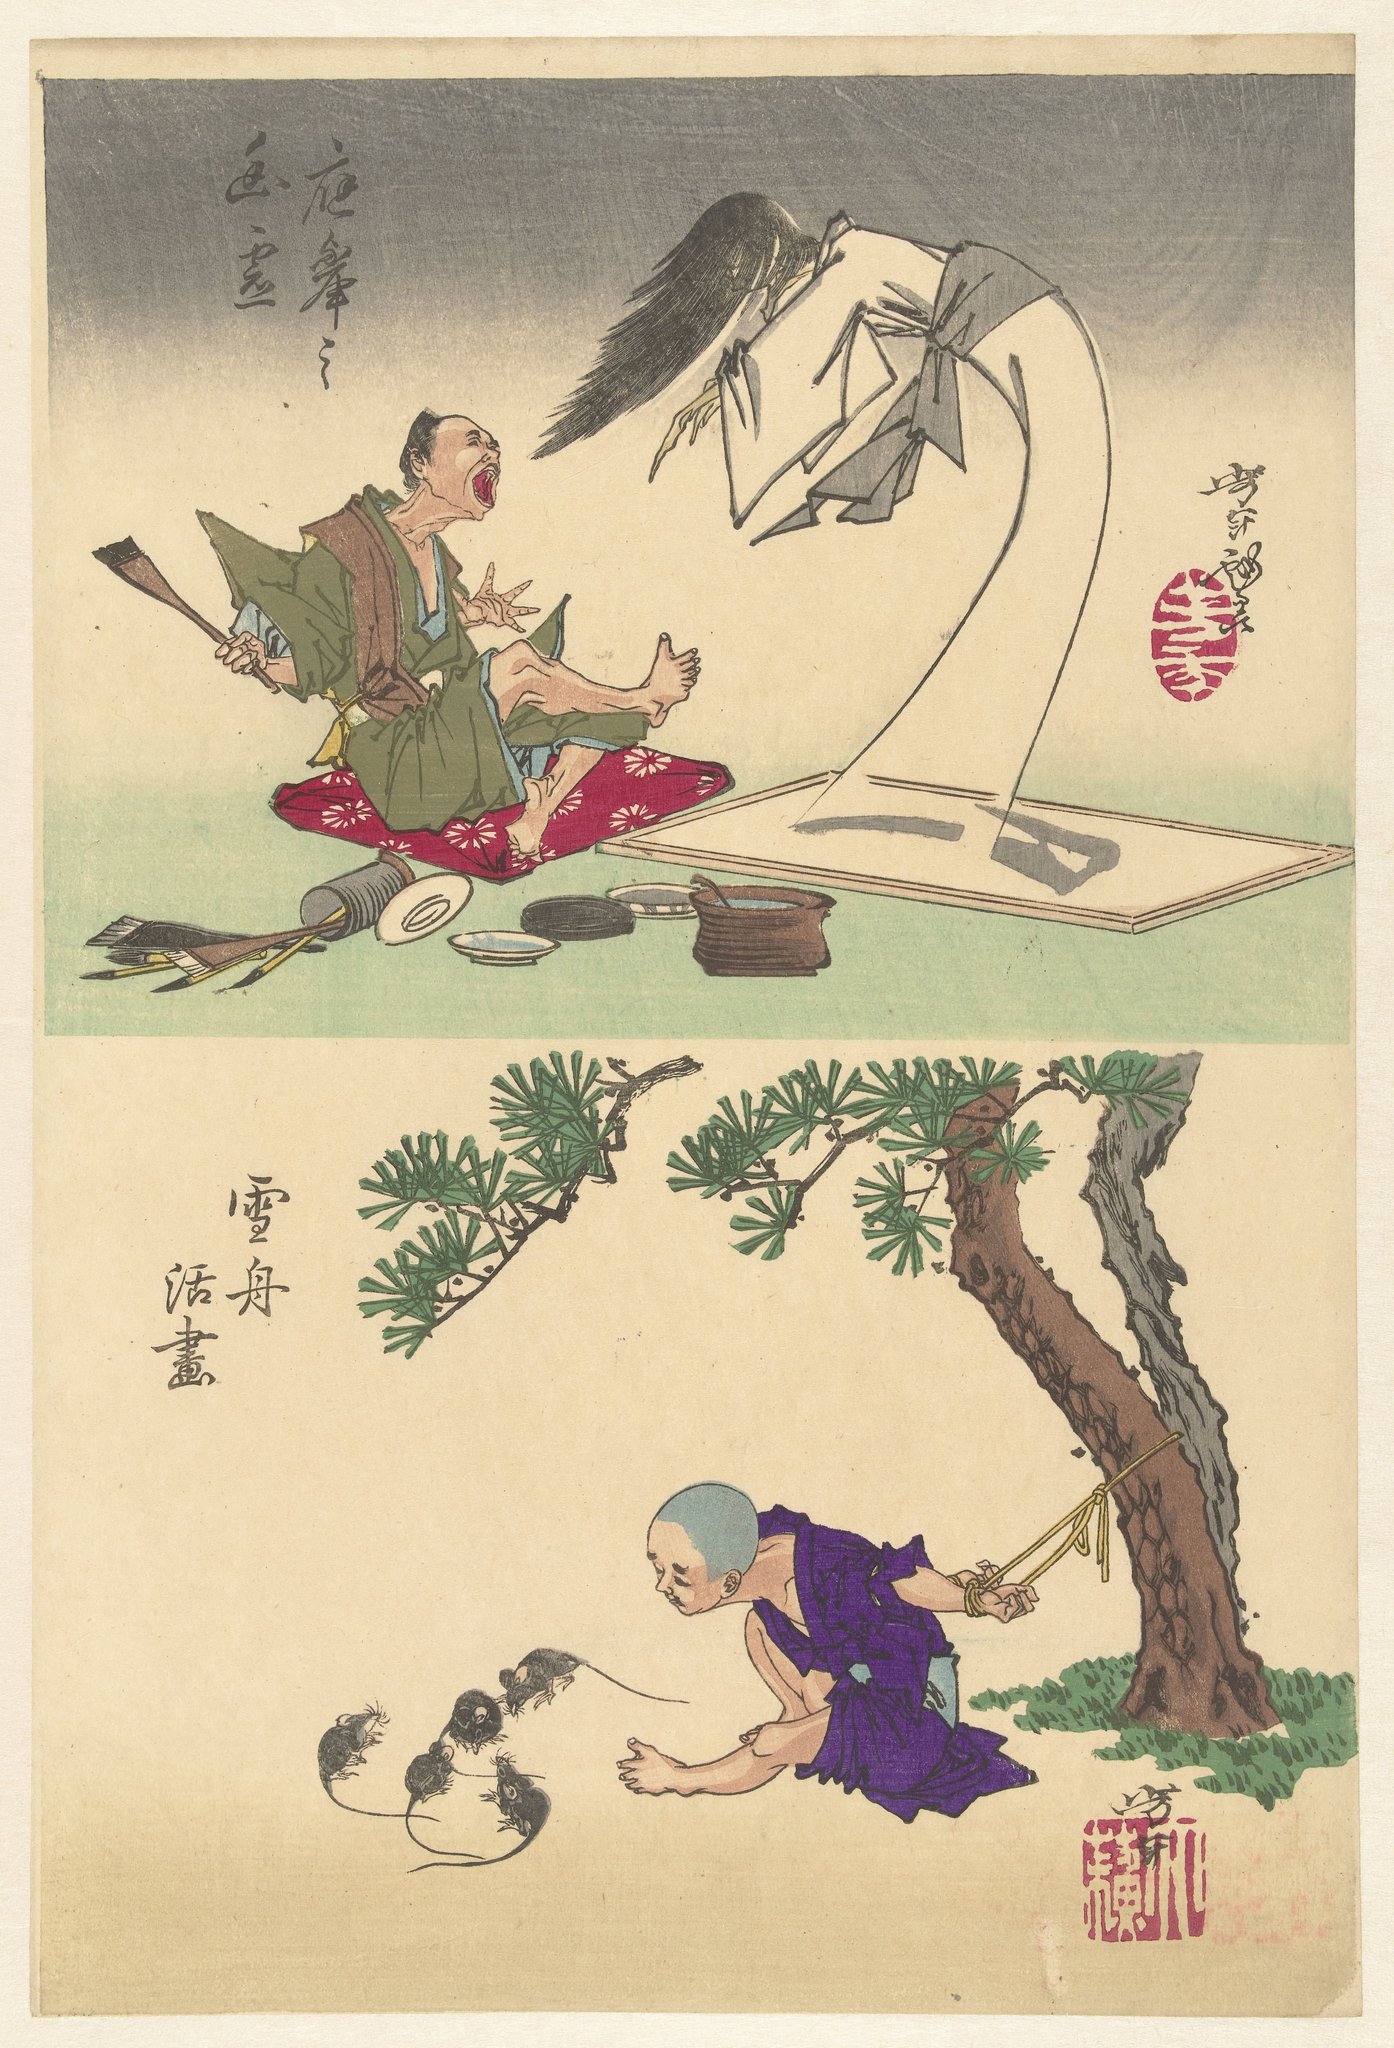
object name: print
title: Sesshu brengt een tekening tot leven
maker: tsukioka yoshitoshi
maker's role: print maker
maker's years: 1839-1892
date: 1882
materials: paper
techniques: woodcut, nishiki e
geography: japan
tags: painter, maruyama ōkyo, sesshu, rodents: mouse, spirit, ghost, artist at work, in his workshop - bb - out of doors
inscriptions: collector's mark: Lugt 2760, collector's mark: Lugt 2228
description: Blad waarop twee prenten in chuban formaat gedrukt. Boven: de schilder Maruyama Okyo schrikkend van het door hem geschilderde spook, dat plotseling tot leven komt. Onder: de schilder Sesshu, als kind, vastgebonden aan een boom na kattenkwaad, kijkend naar de tot leven gekomen muizen die hij met zijn teen in het zand tekende.